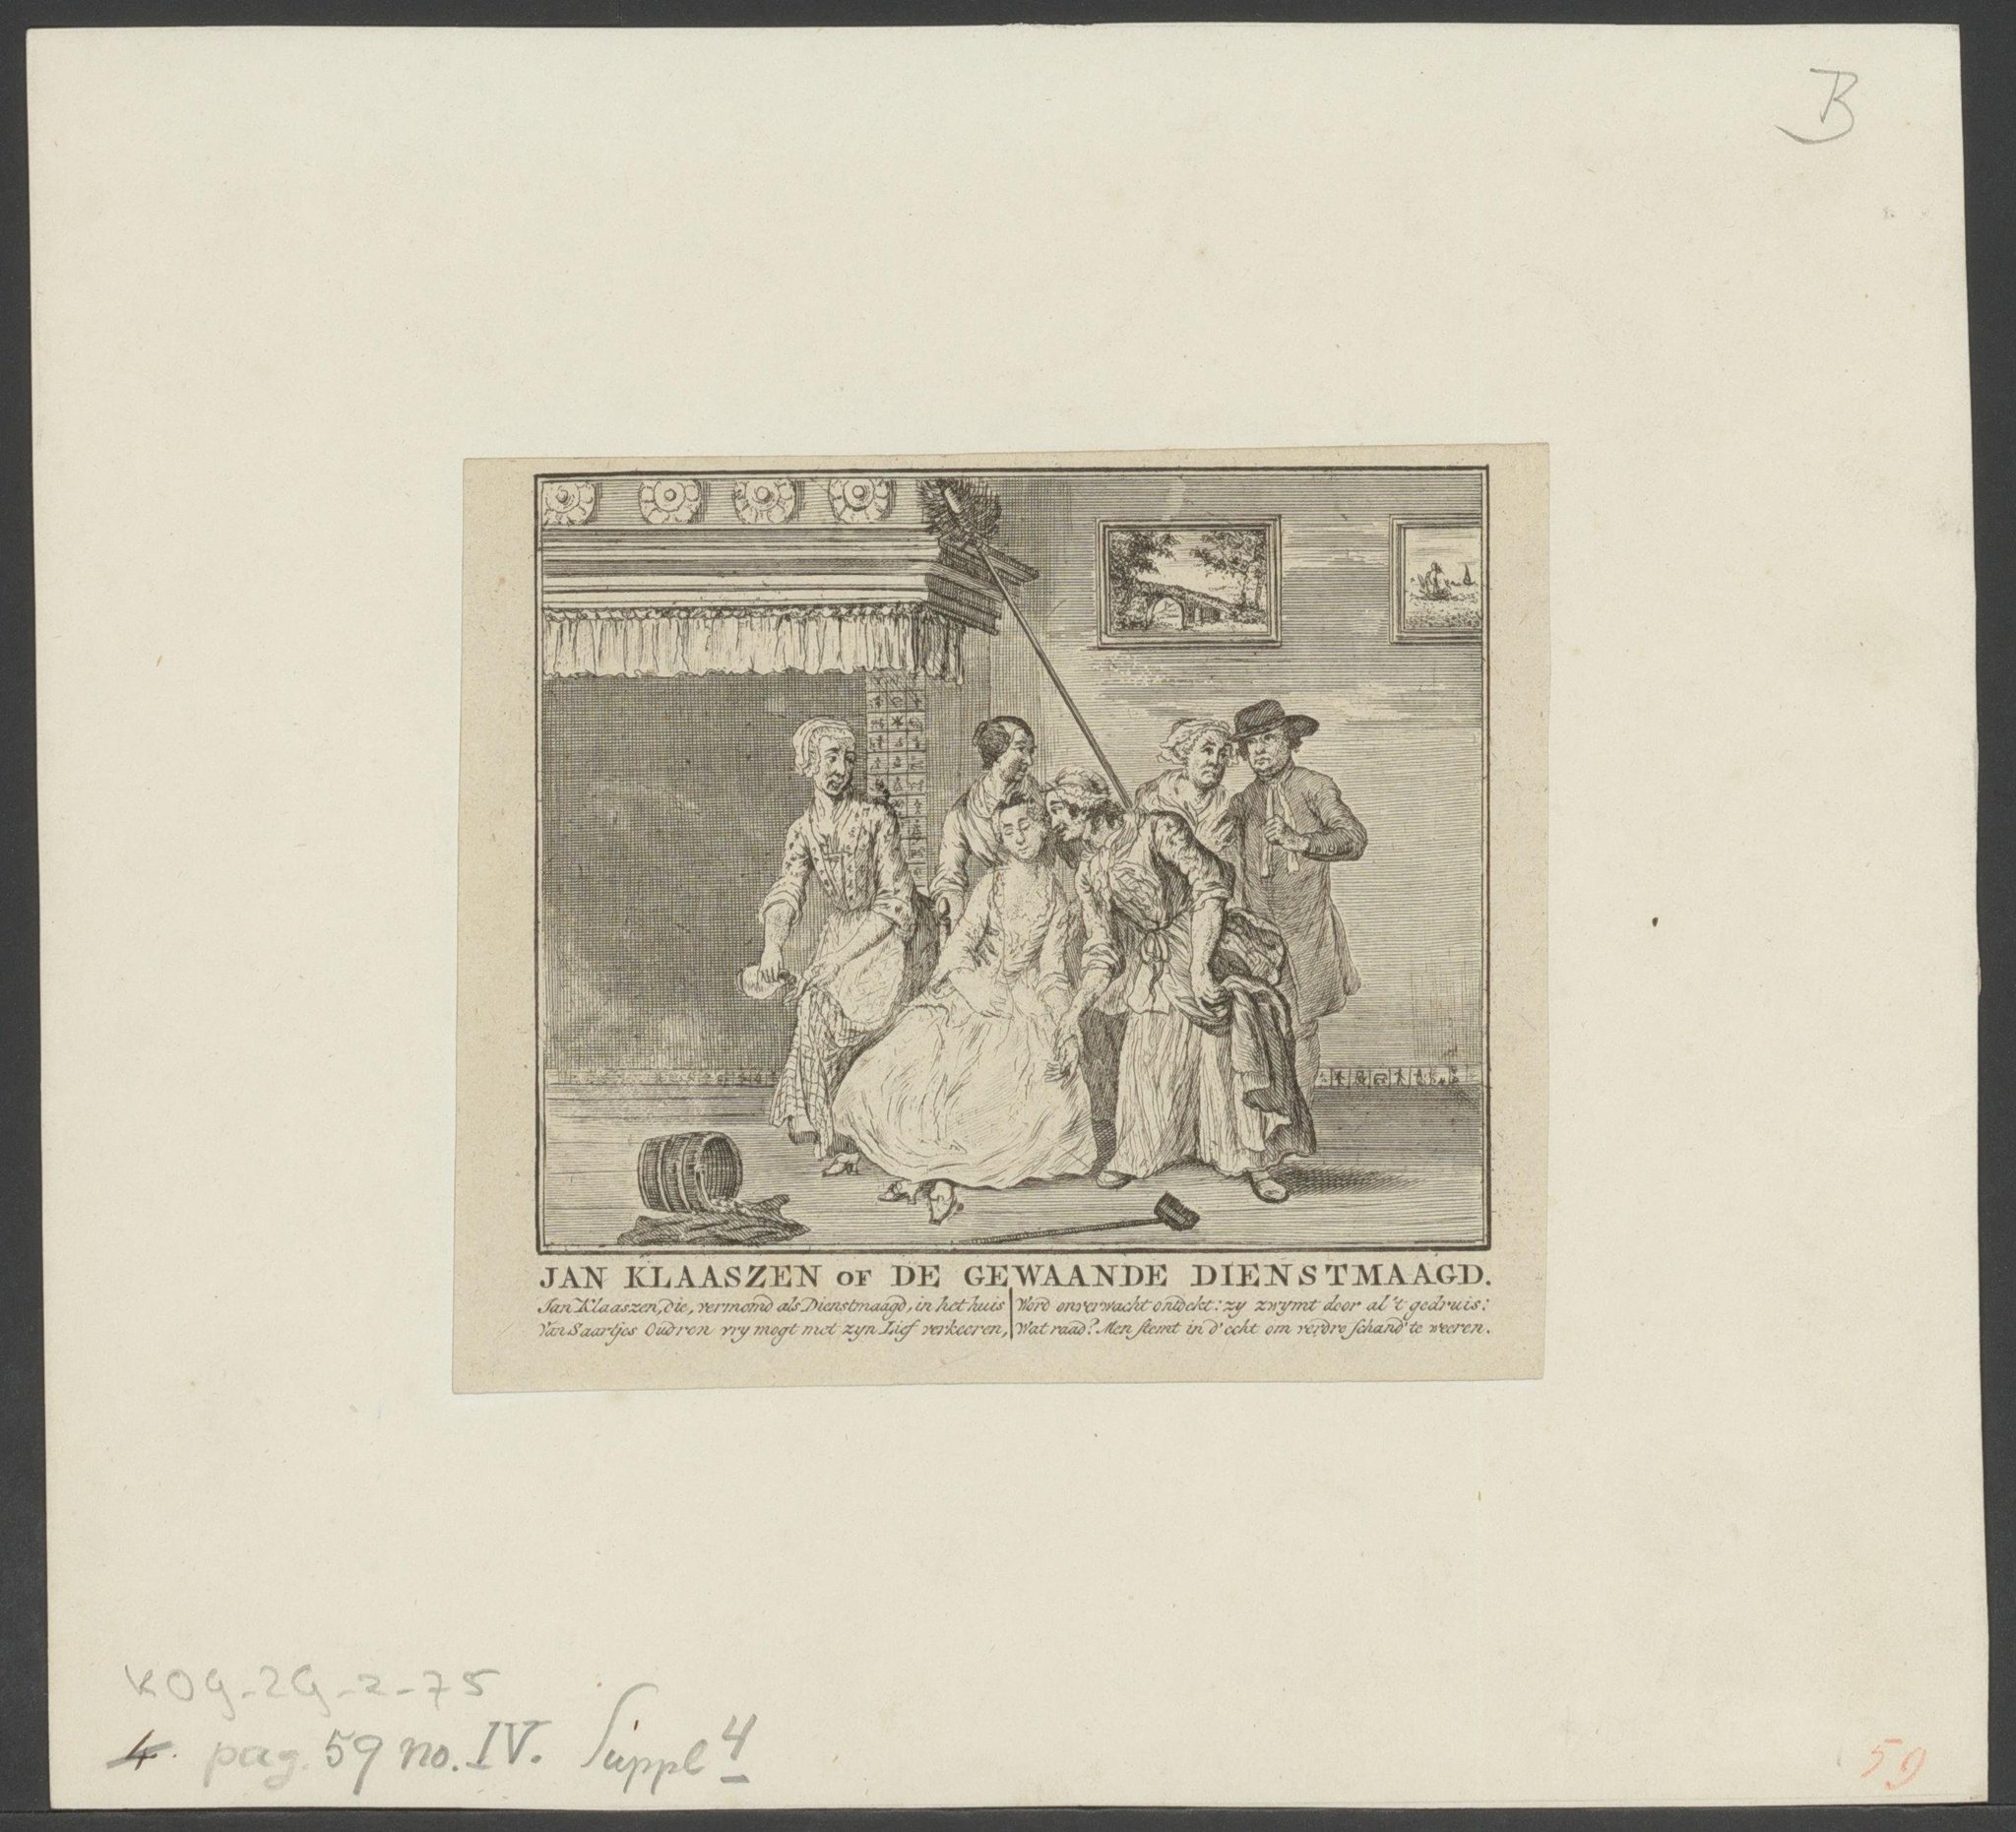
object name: print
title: Interieur met Saartje op een stoel, omringd door huispersoneel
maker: Anonymous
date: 1755-1799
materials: paper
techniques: engraving, etching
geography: netherlands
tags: man dressed as woman, travesty, maid ~ house personnel, comedy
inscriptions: collector's mark: Lugt 2488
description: Saartje valt in zwijm als ontdekt wordt dat haar geliefde Jan Klaaszen zich vermomd had als dienstmeid, om zo bij haar te kunnen zijn. Onderaan in de marge een vierregelige vers in het Nederlands.